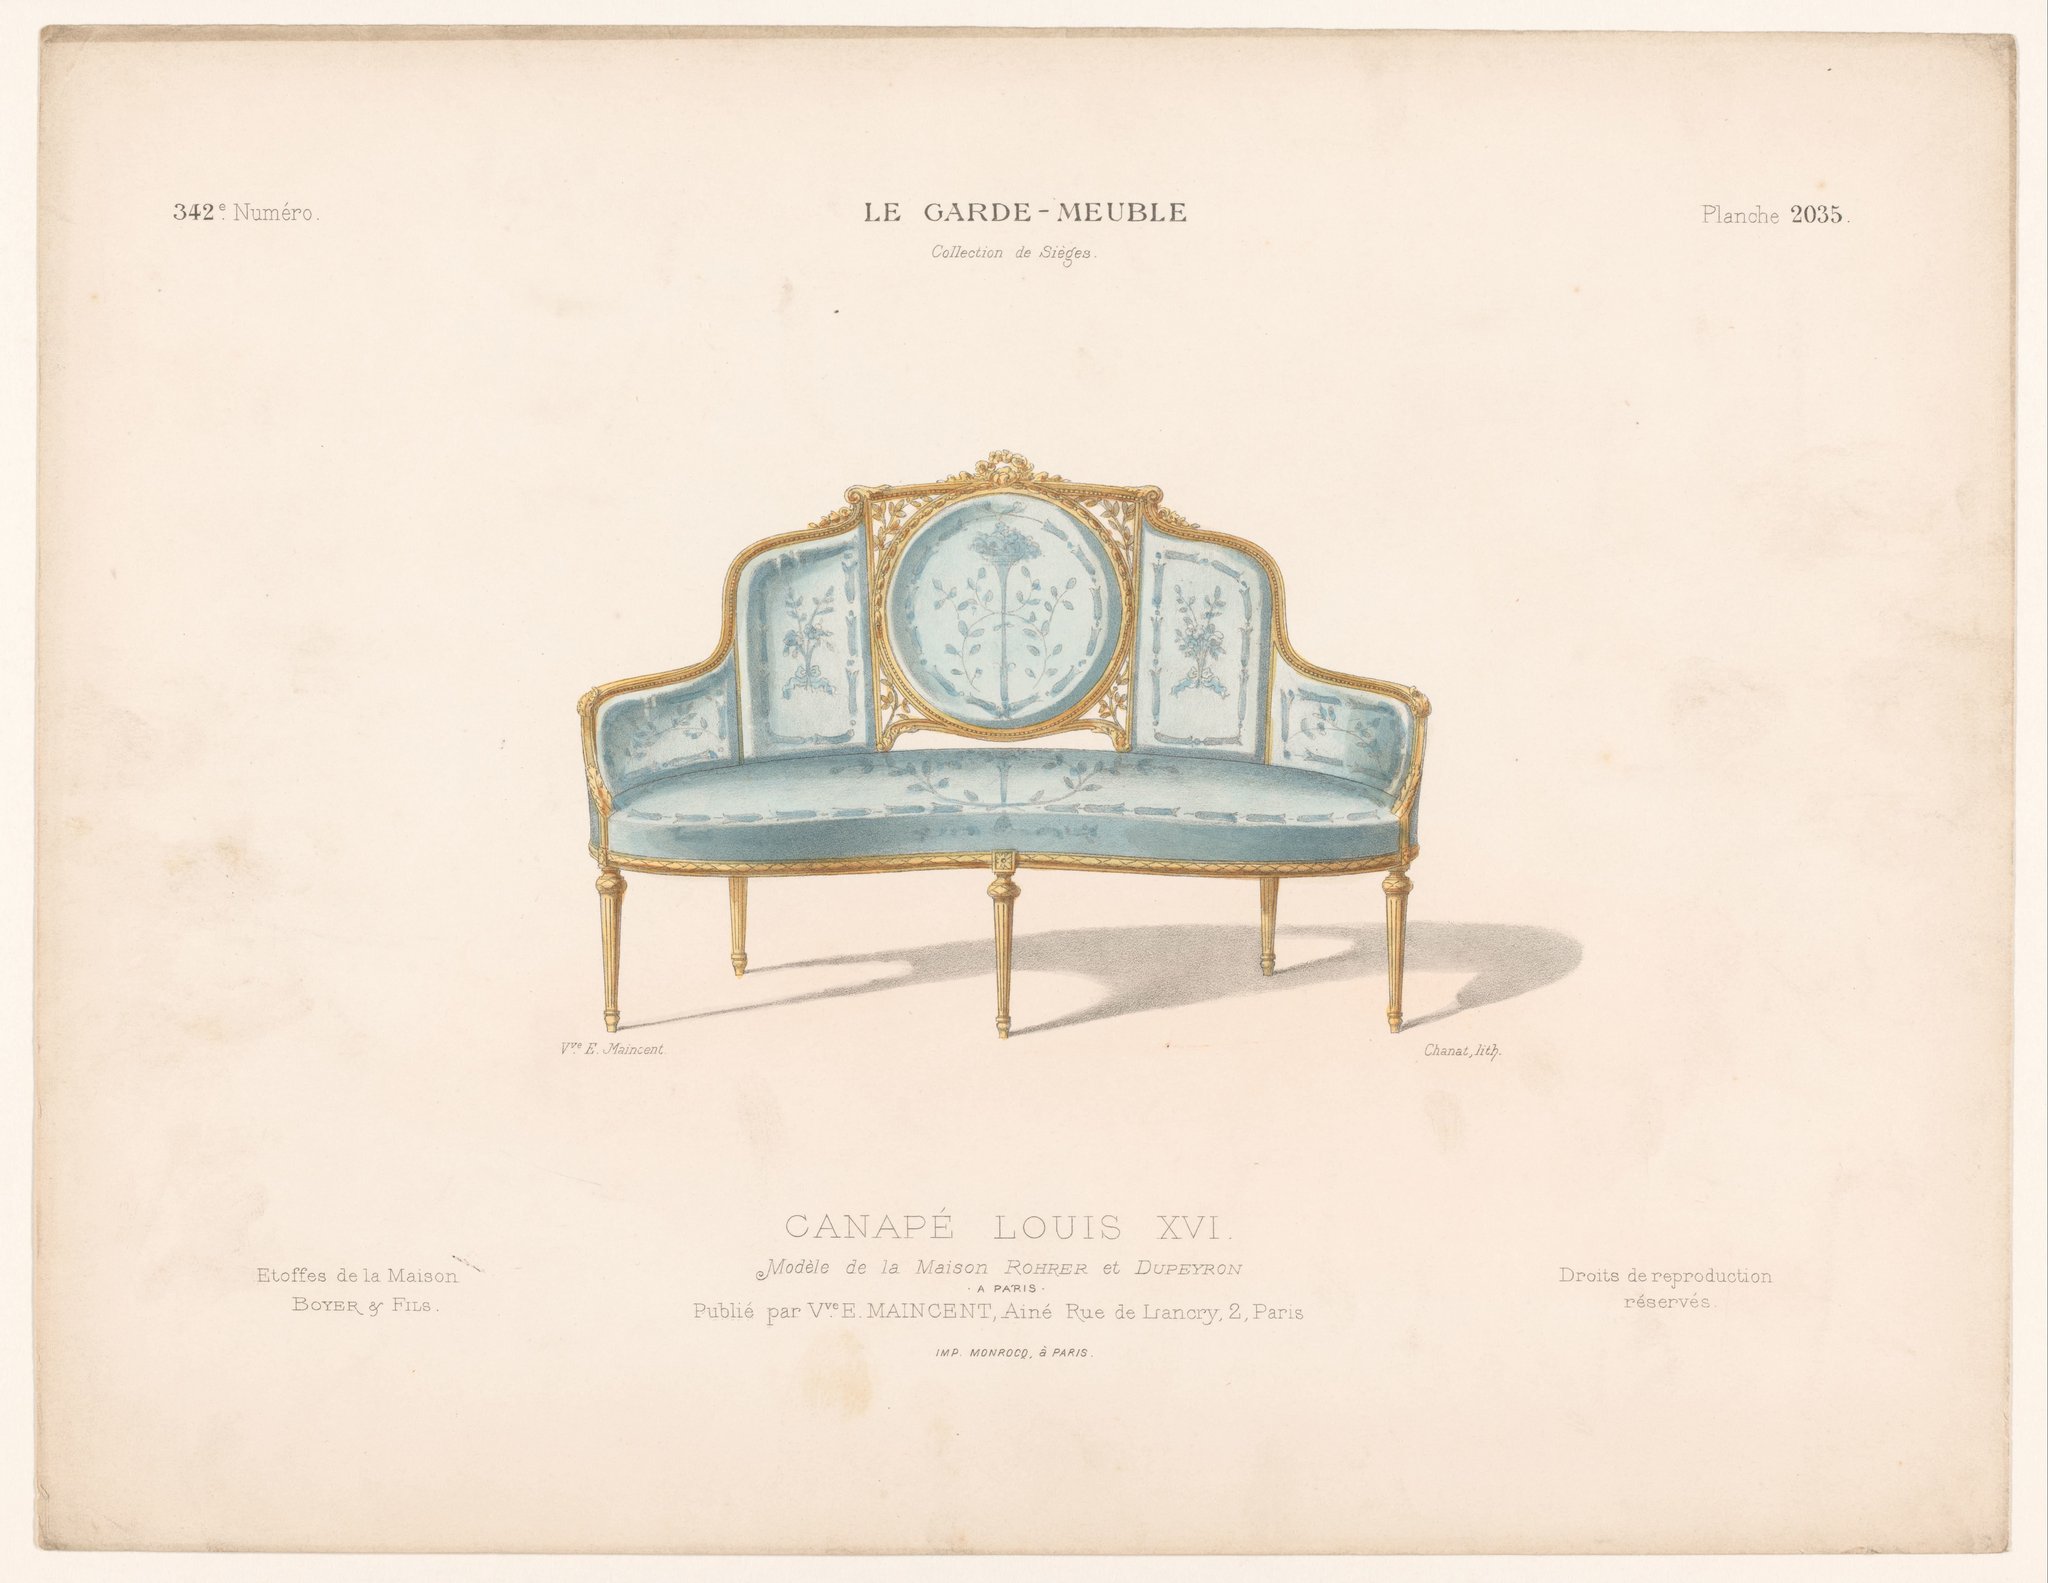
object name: print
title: Le garde-meuble / Collection de Sièges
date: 1895-1935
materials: paper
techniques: hand coloring, lithograph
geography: paris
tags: seating furniture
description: Ieder Livraison in de serie Le Garde-Meuble bevat negen platen: drie 'sièges' (zitmeubels), drie 'meubles' (diverse meubels zoals tafels en kasten) en drie 'tentures' (gordijnen en draperieën).